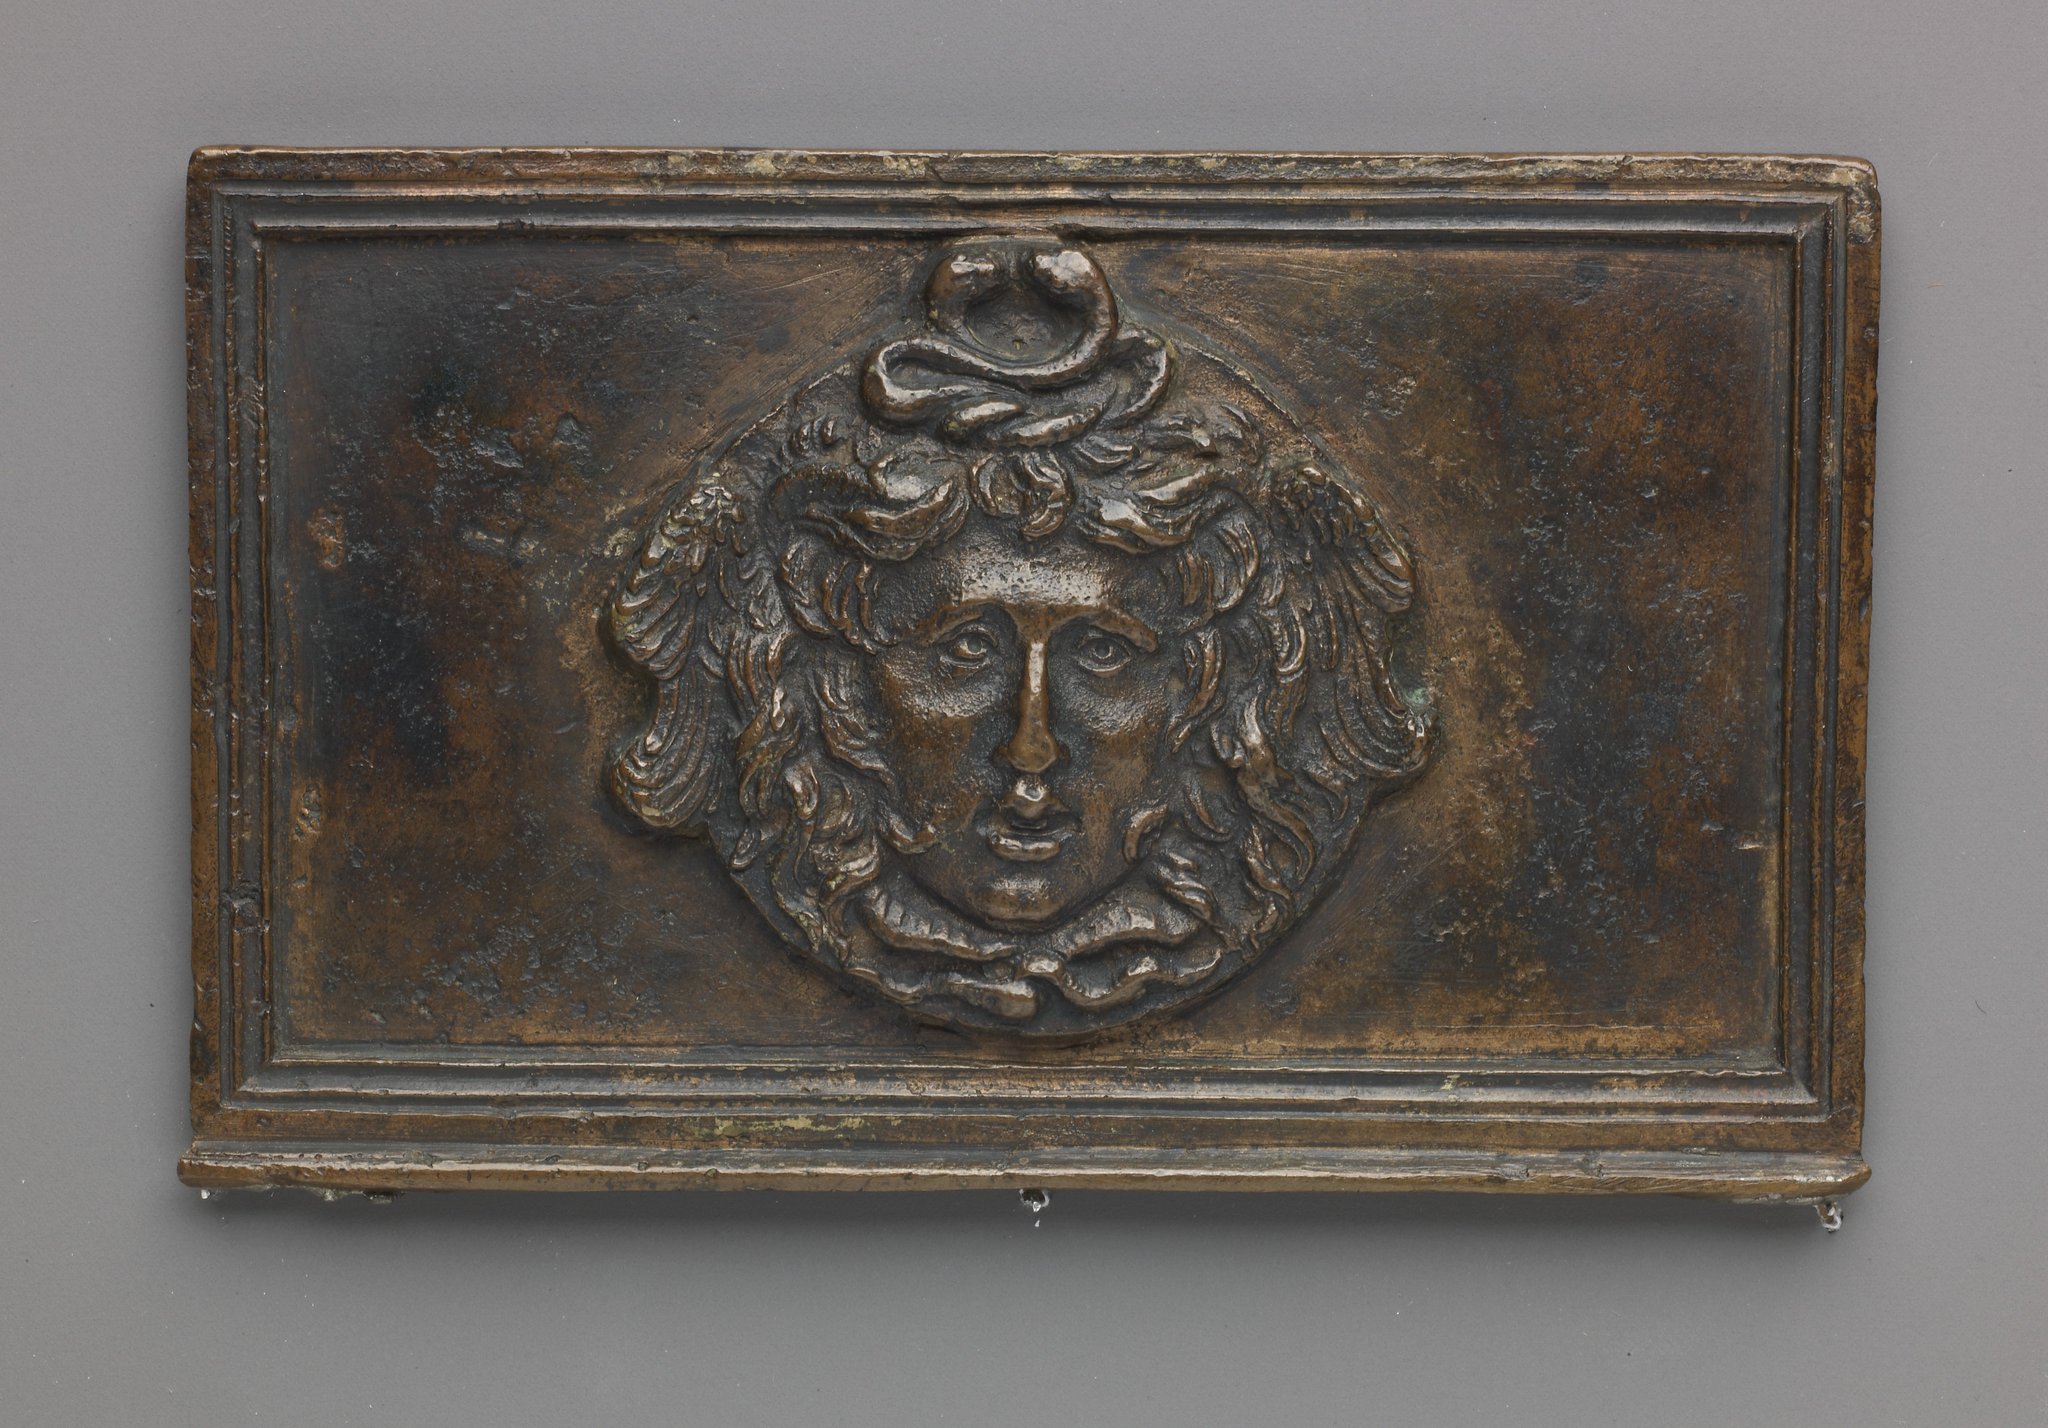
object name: plaquette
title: Medusa mask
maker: severo calzetta da ravenna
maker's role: artist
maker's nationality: italian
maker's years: 1496-1543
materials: copper alloy, patina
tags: medusa